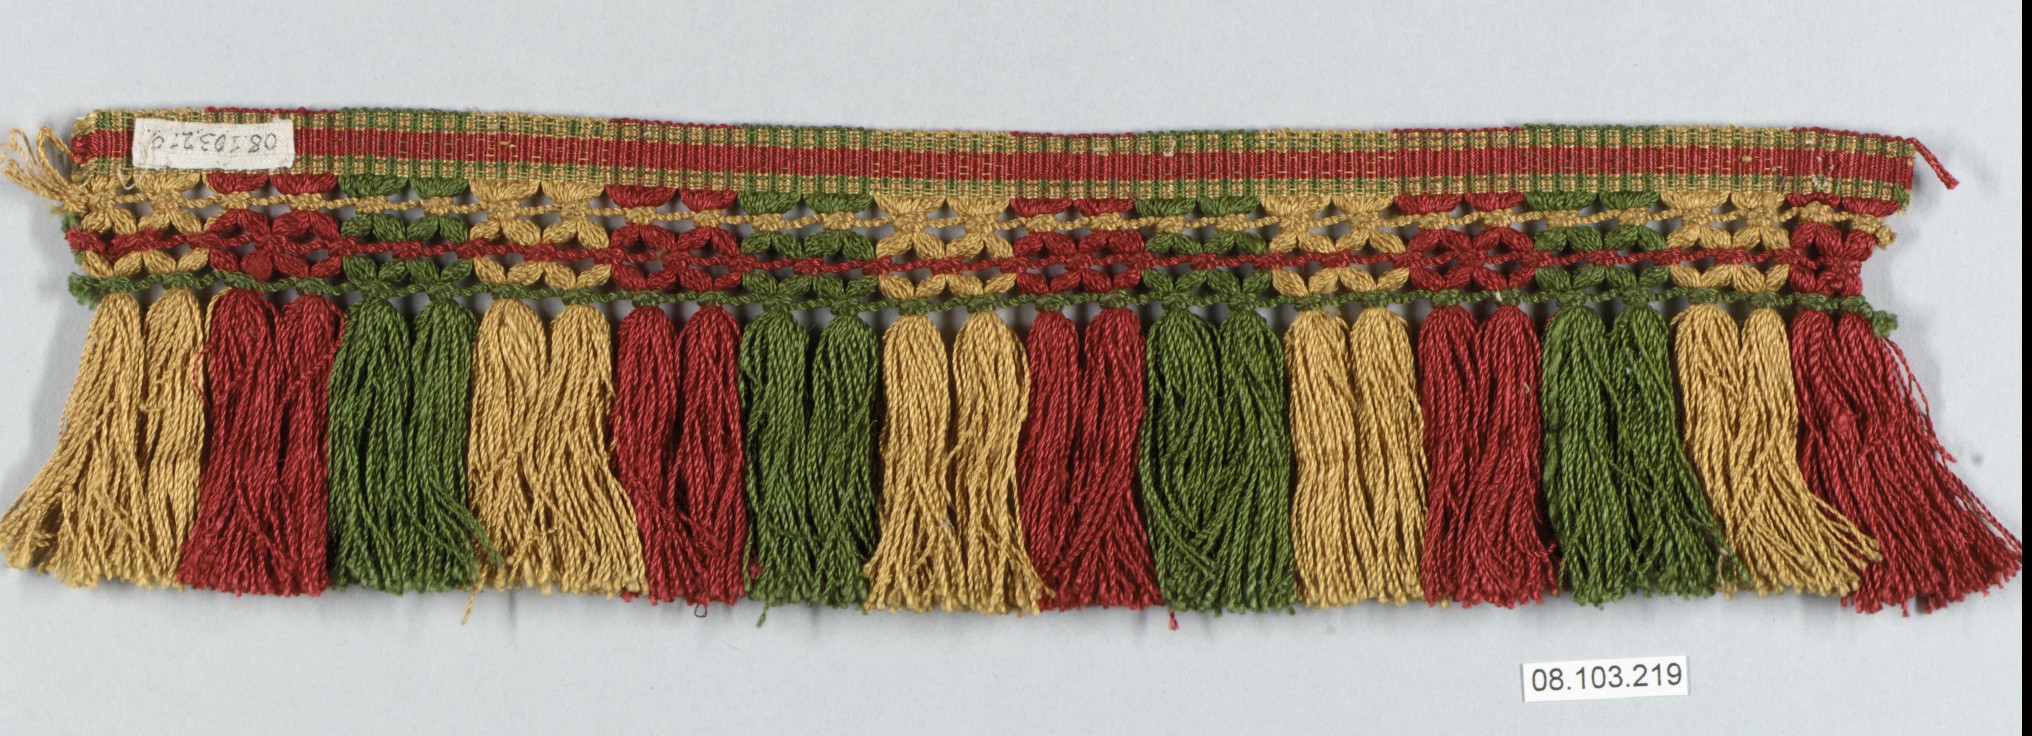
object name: fringe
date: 1601-1700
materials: silk